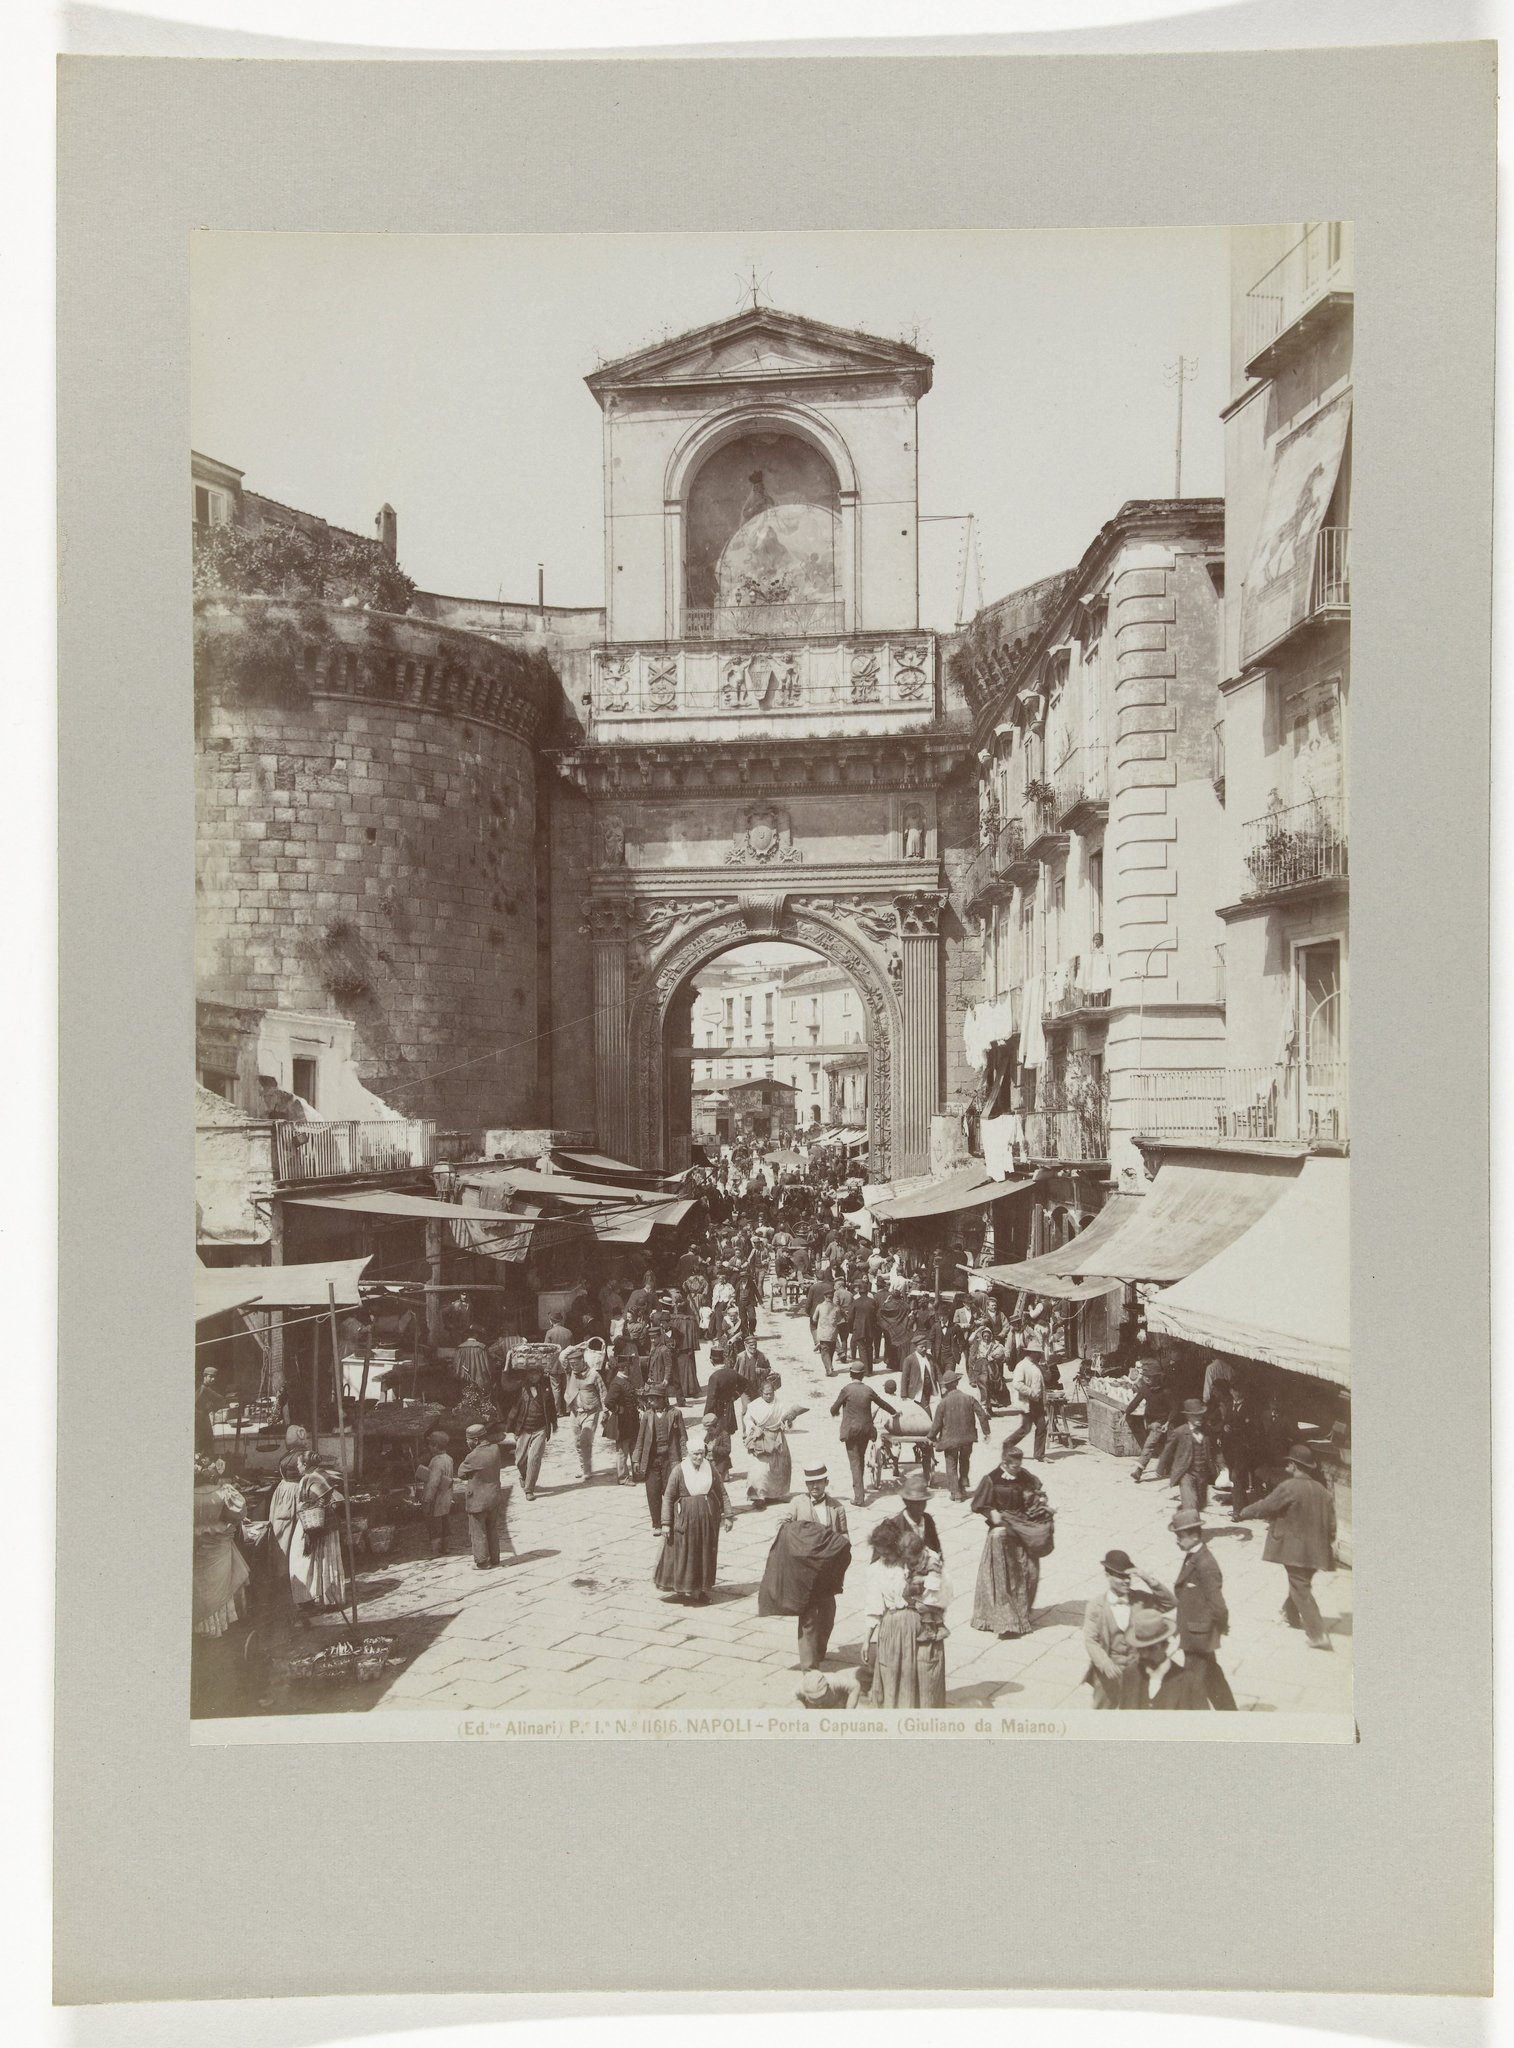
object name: photograph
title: Porta Capuana te Napels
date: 1880-1895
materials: cardboard, paper, photographic support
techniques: albumen print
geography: florence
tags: gate, entrance, market, street, naples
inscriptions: number: ‘52.’